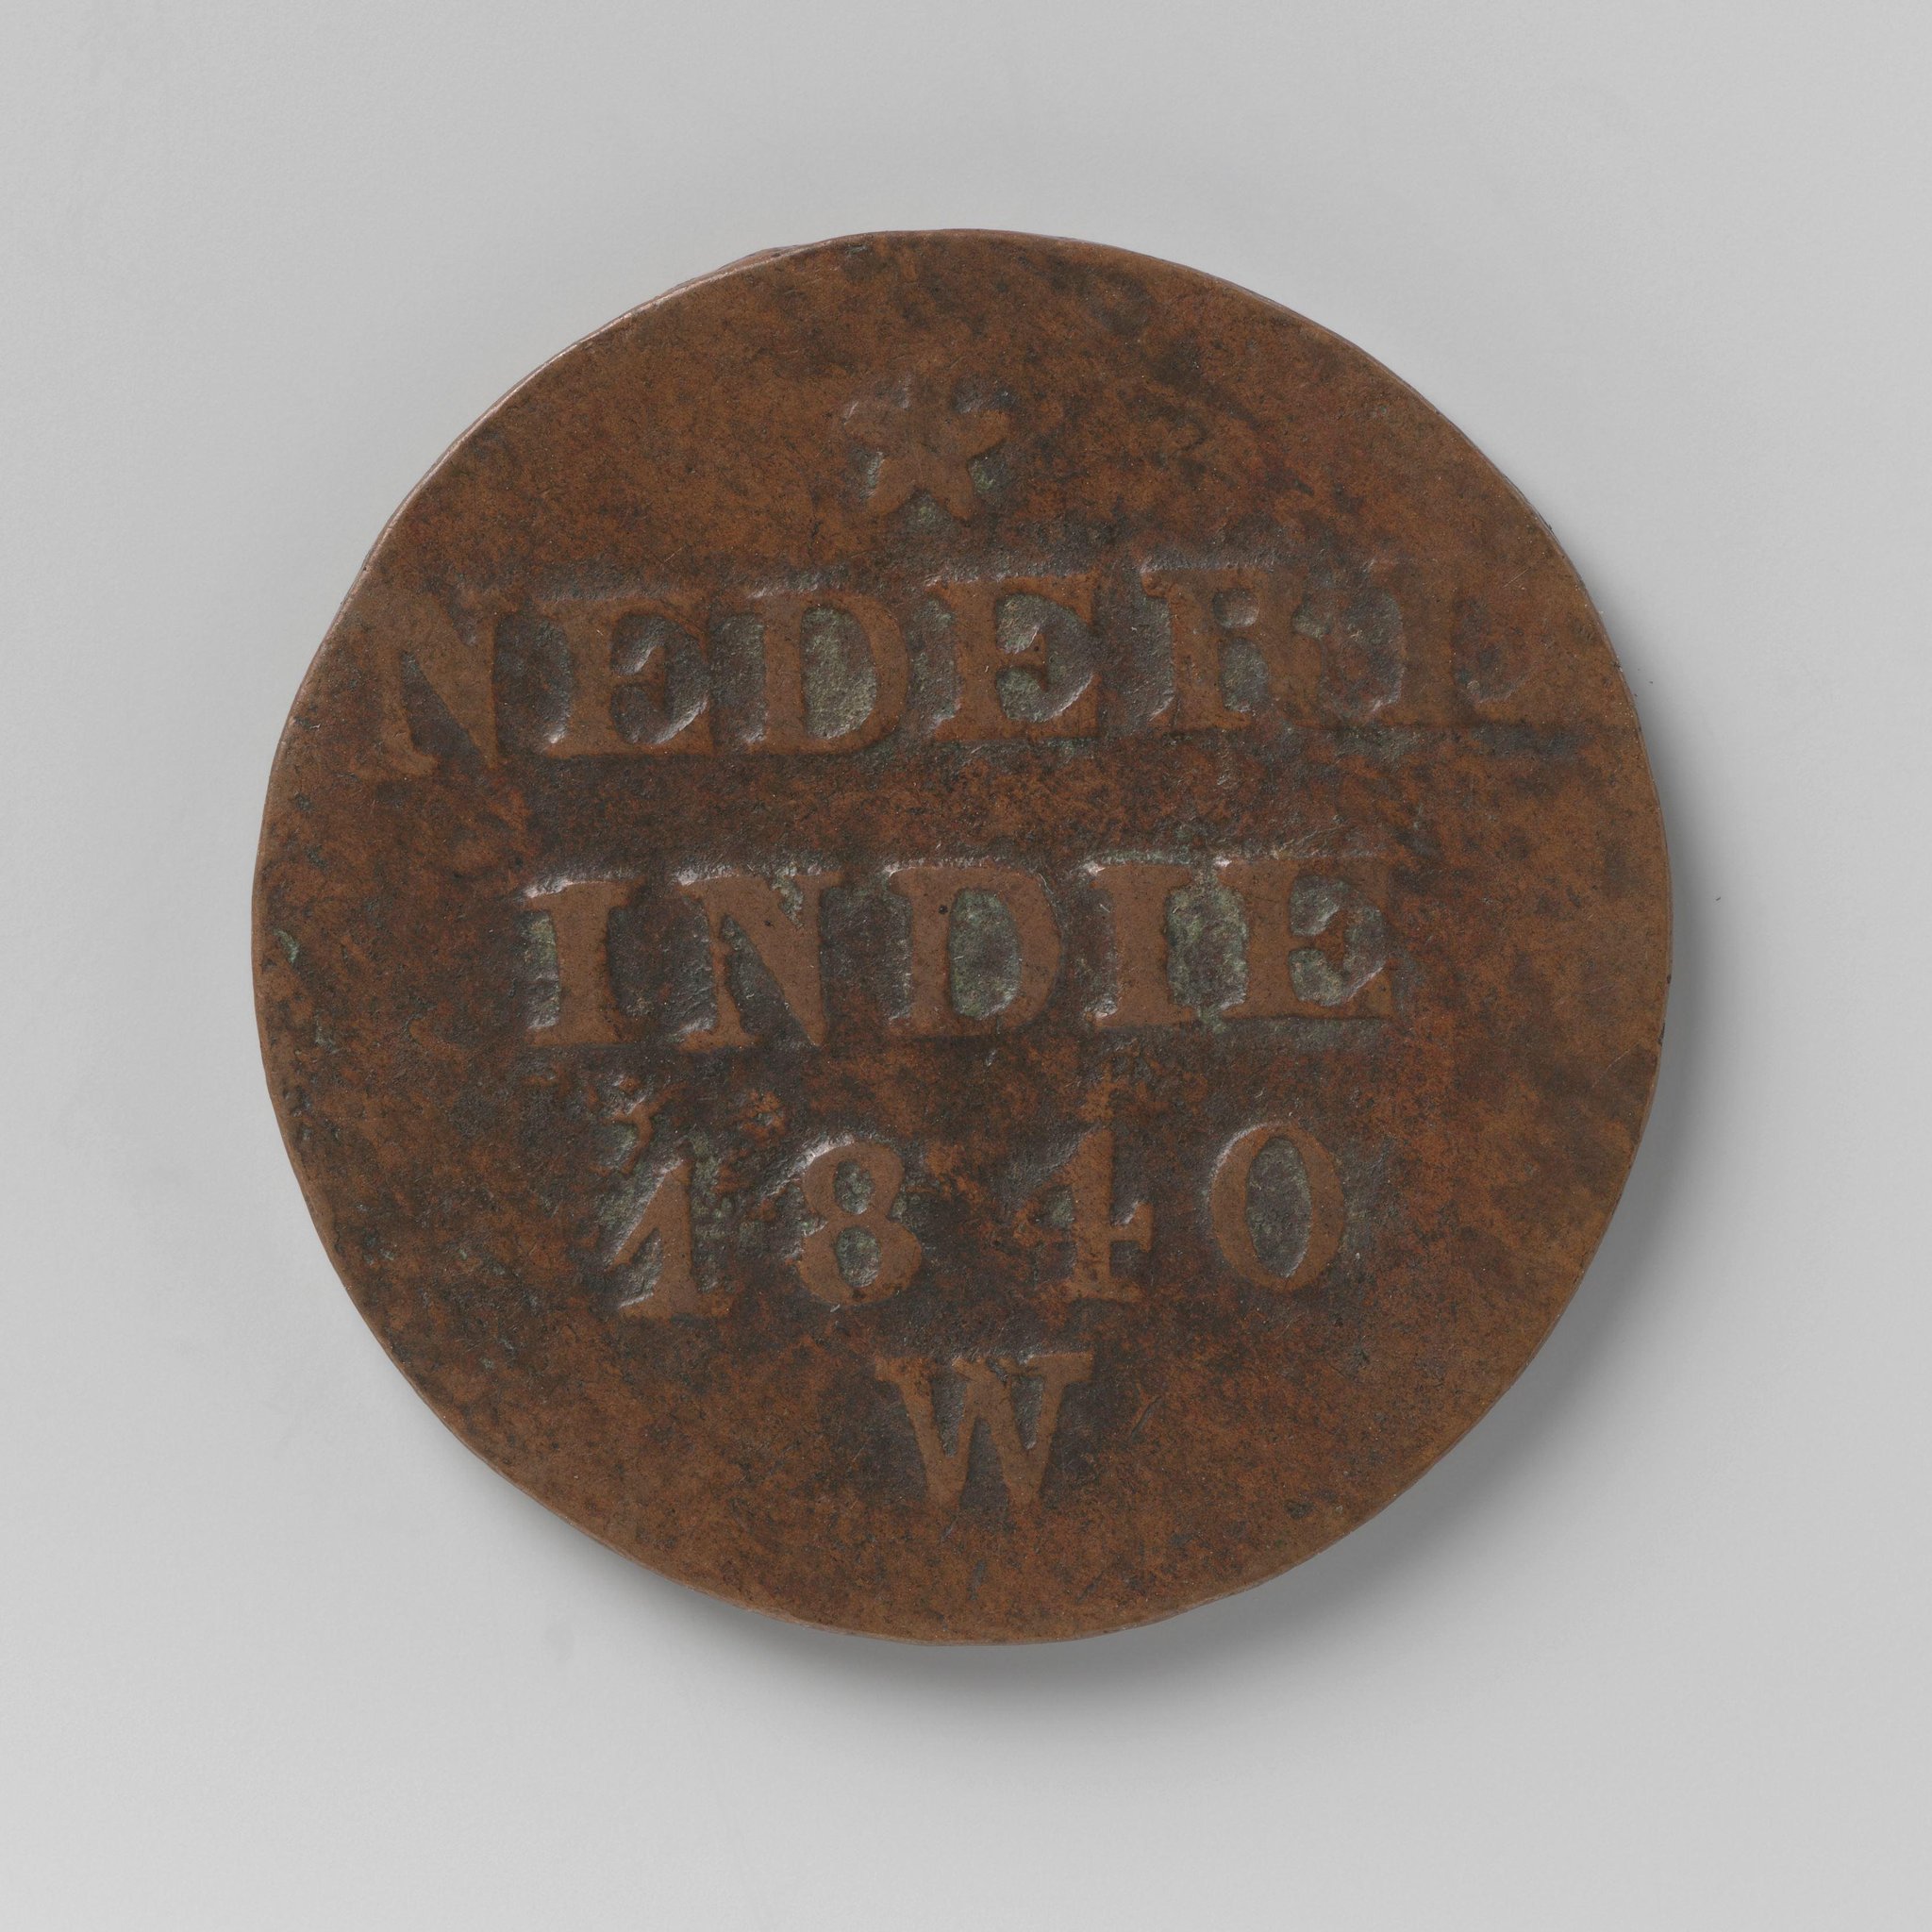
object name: coin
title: 2 cent van Nederlands Indië,1840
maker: william i of the netherlands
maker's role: koning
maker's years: 1772-1843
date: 1840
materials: copper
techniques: striking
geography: surabaya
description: Koperen munt. Voorzijde: tussen waarde-aanduiding 2 CT. gekroond rijkswapenschild. Keerzijde: tweeregelig opschrift, waarboven muntteken en waaronder jaartal. Daaronder letter W [=muntmeester Wilmans]. Gladde rand.